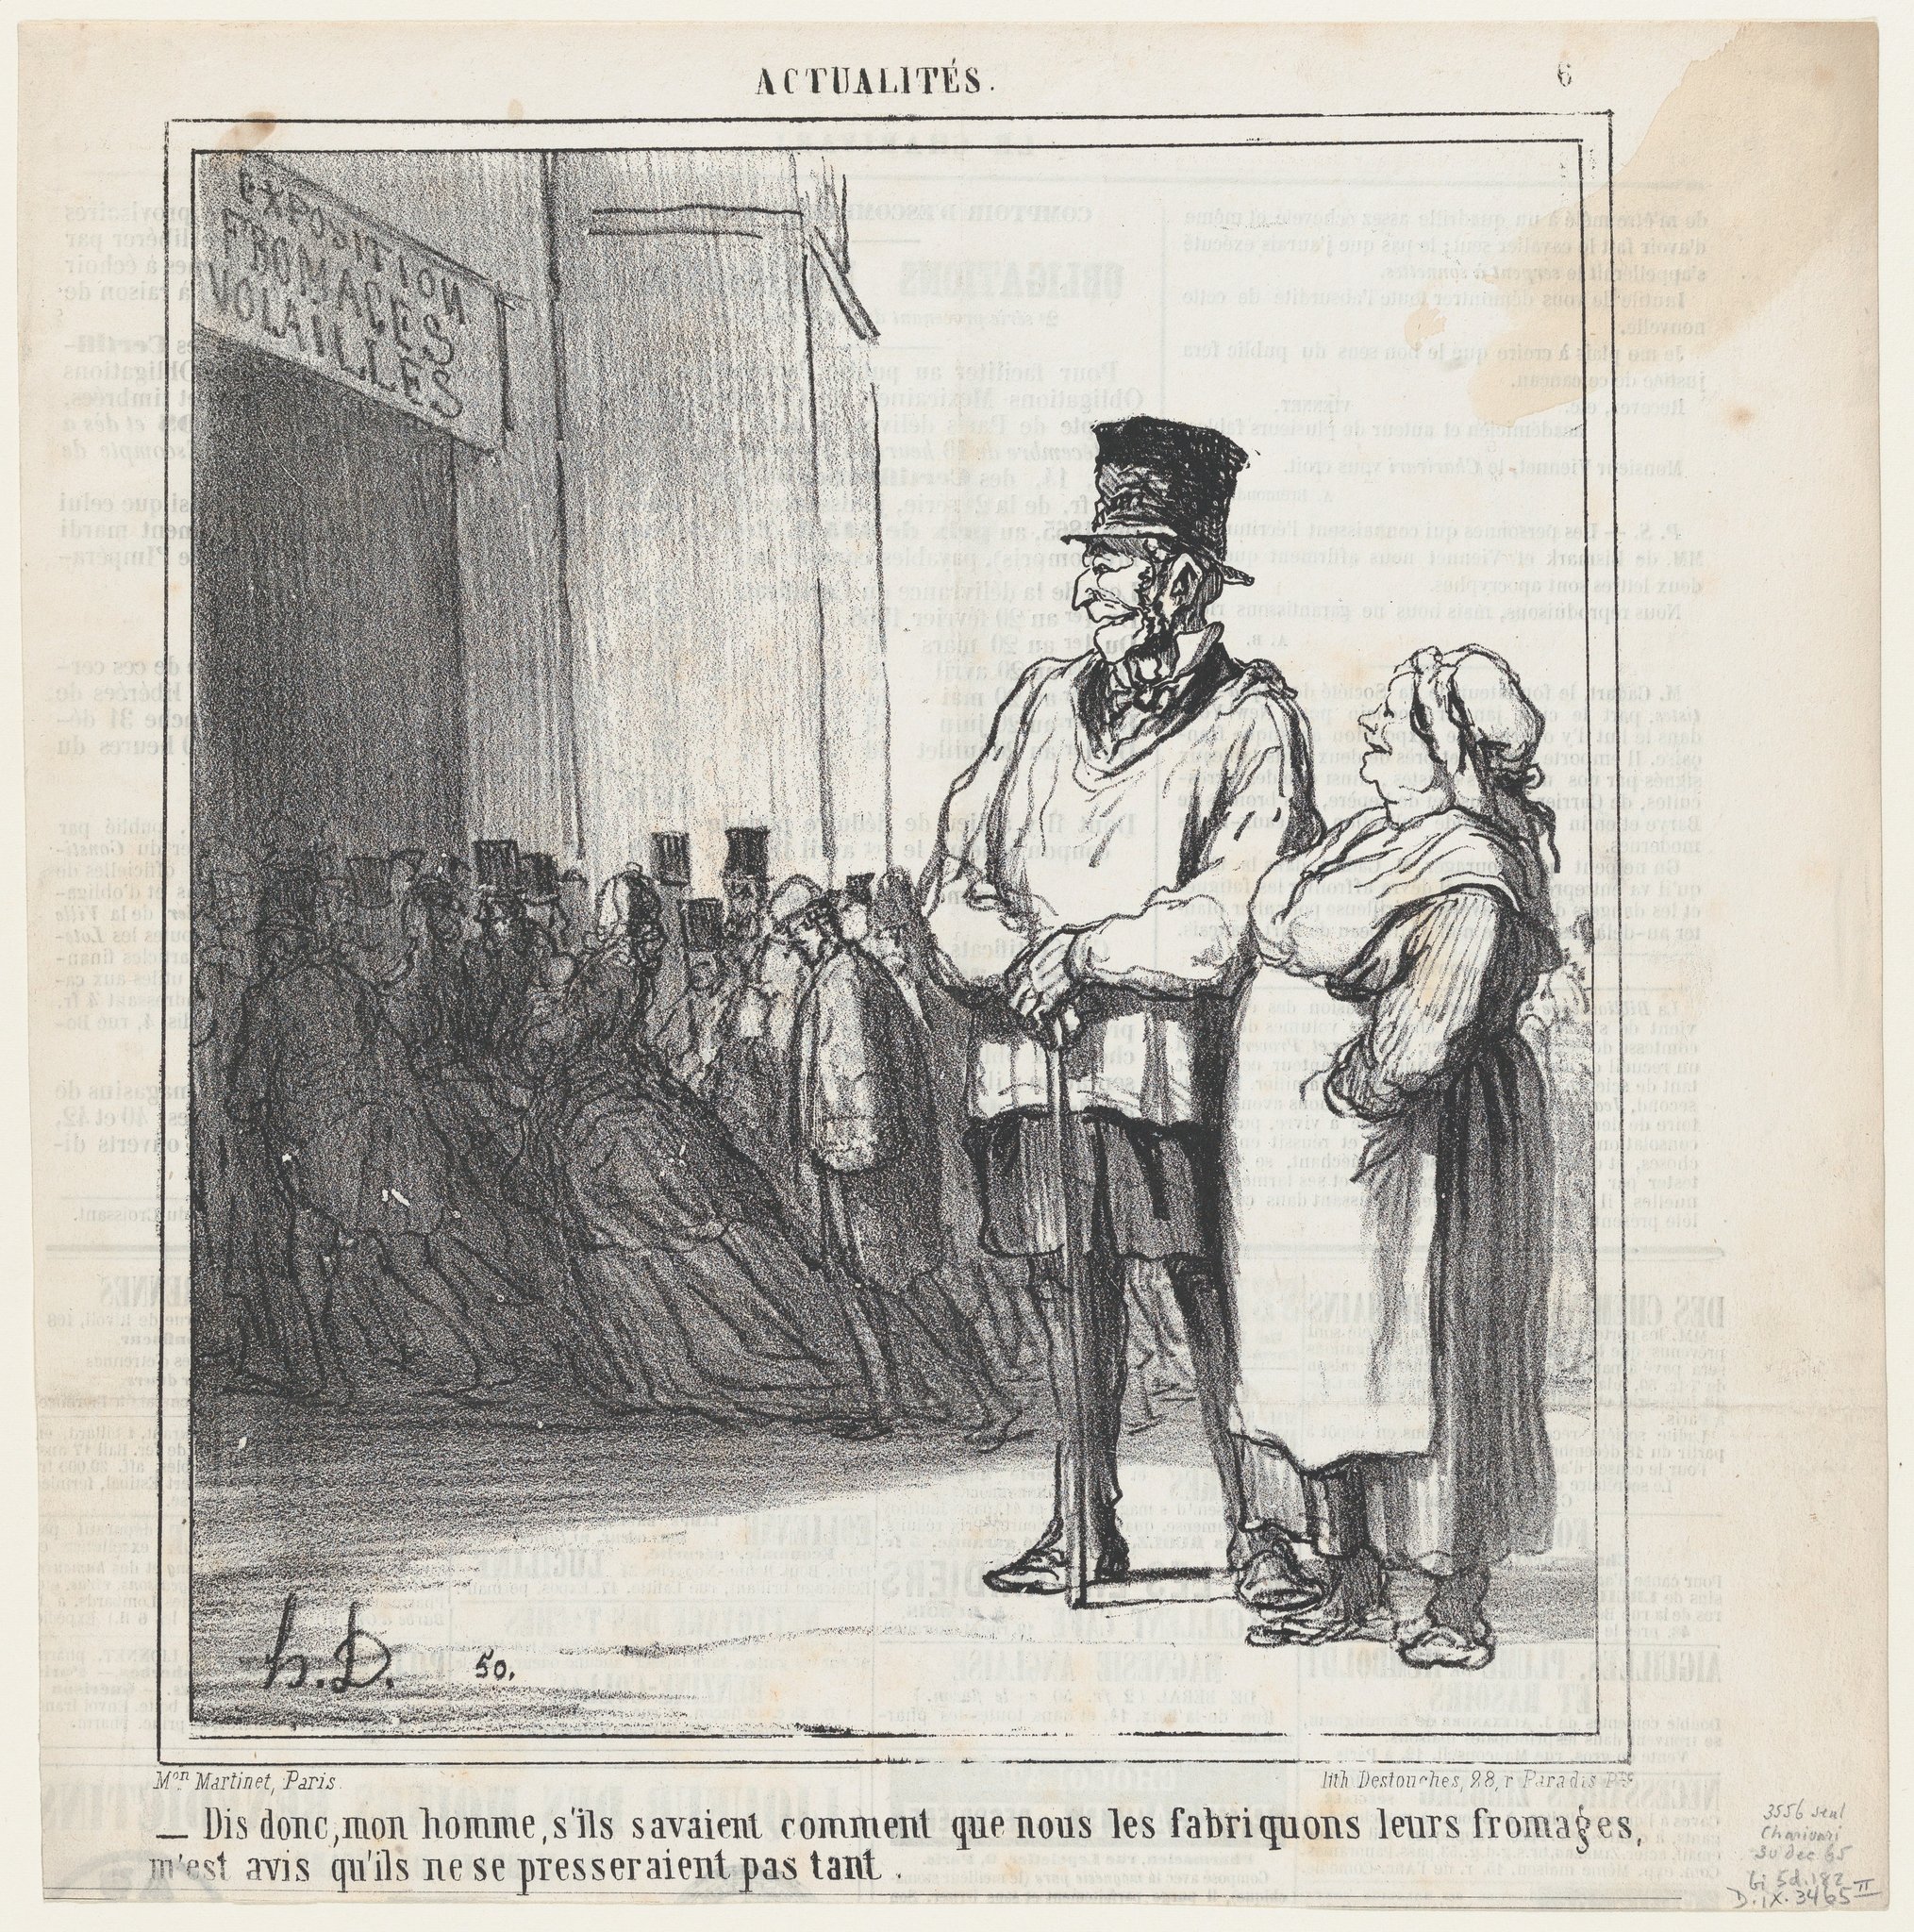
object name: print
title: Just imagine my good fellow.... if they knew how we make their cheese, they surely wouldn't hurry so much, from 'News of the day,' published in Le Charivari, December 30, 1865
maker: honoré daumier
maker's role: artist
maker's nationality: french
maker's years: 1808-1879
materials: paper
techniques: lithograph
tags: satire,men,women